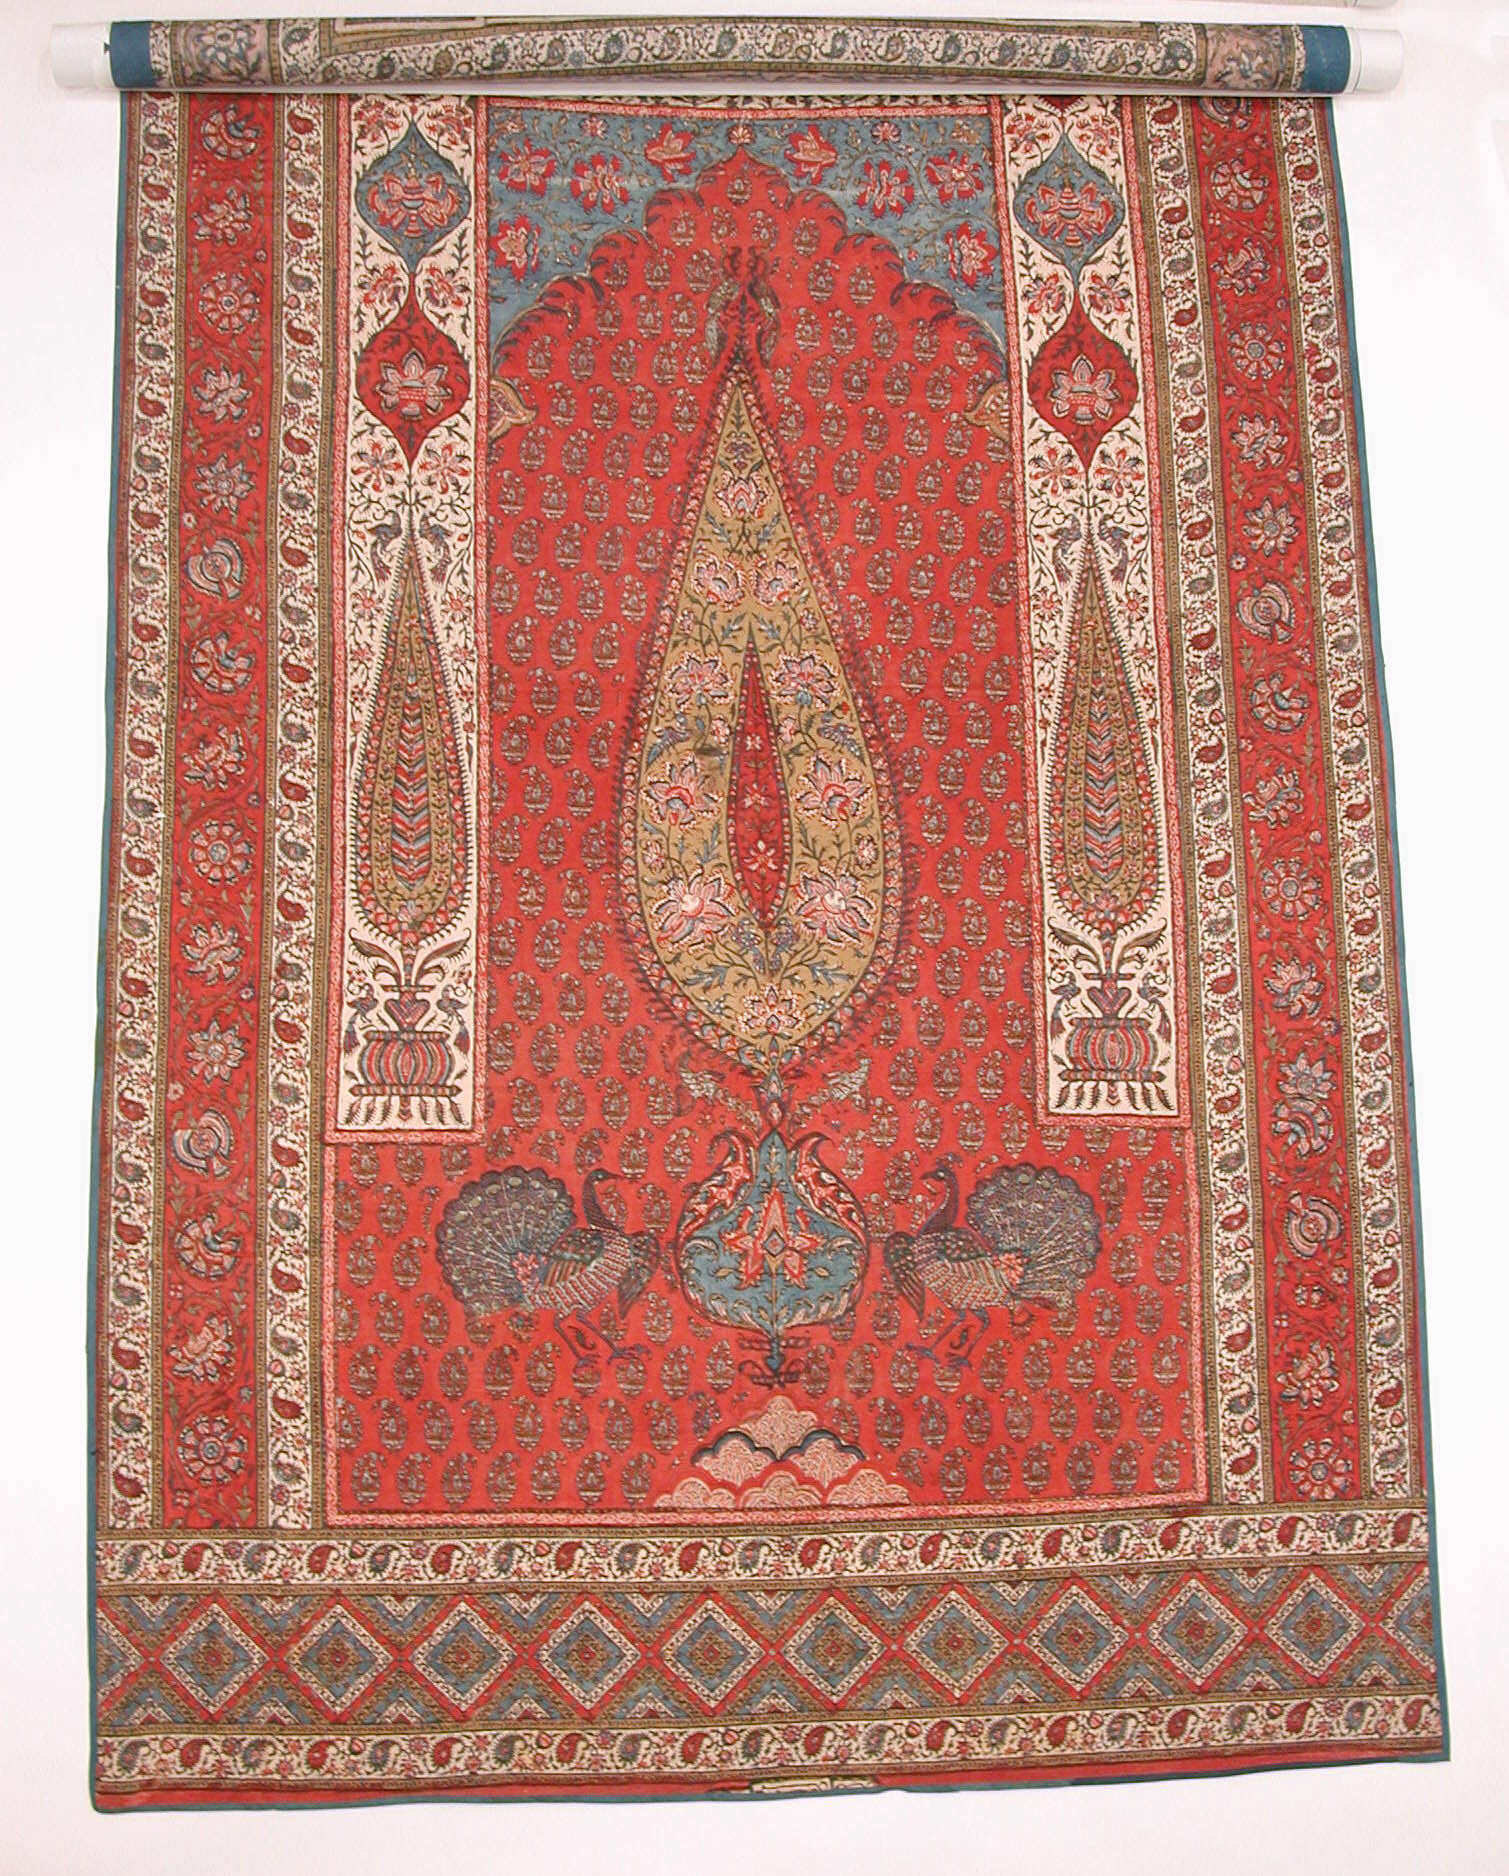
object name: hanging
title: Hanging (Kalemkar)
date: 1801-1850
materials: cotton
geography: india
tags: peacocks